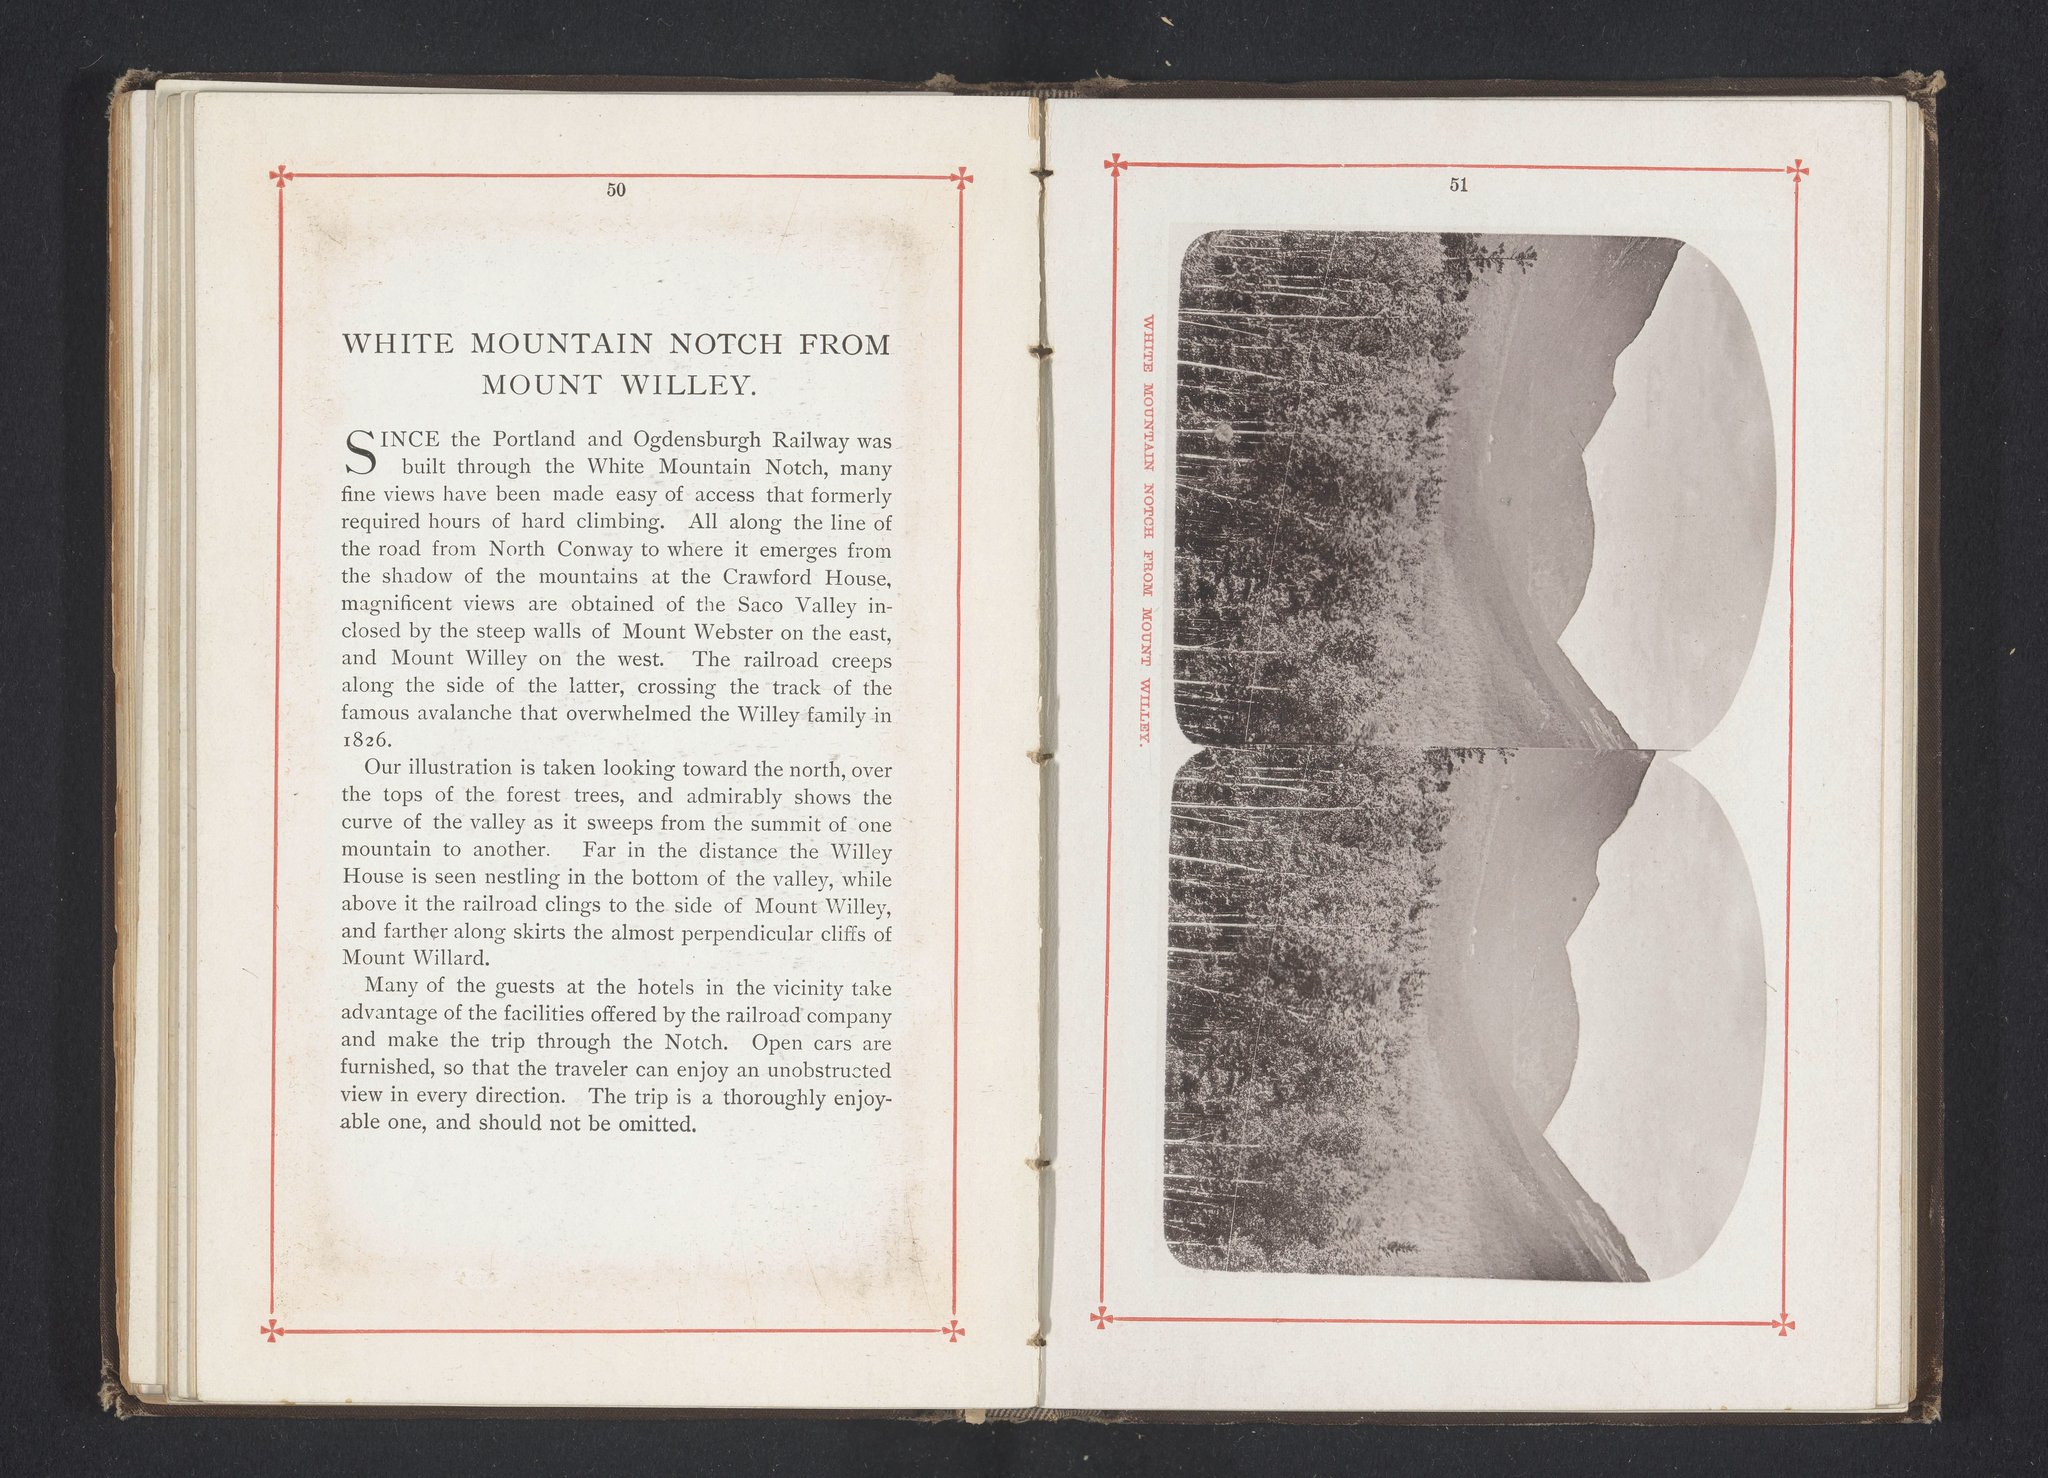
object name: stereograph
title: Gezicht op White Mountain in het Crawford Notch State Park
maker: Anonymous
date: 1873-1878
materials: paper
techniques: photograph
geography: mount willey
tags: dale, valley, mountains